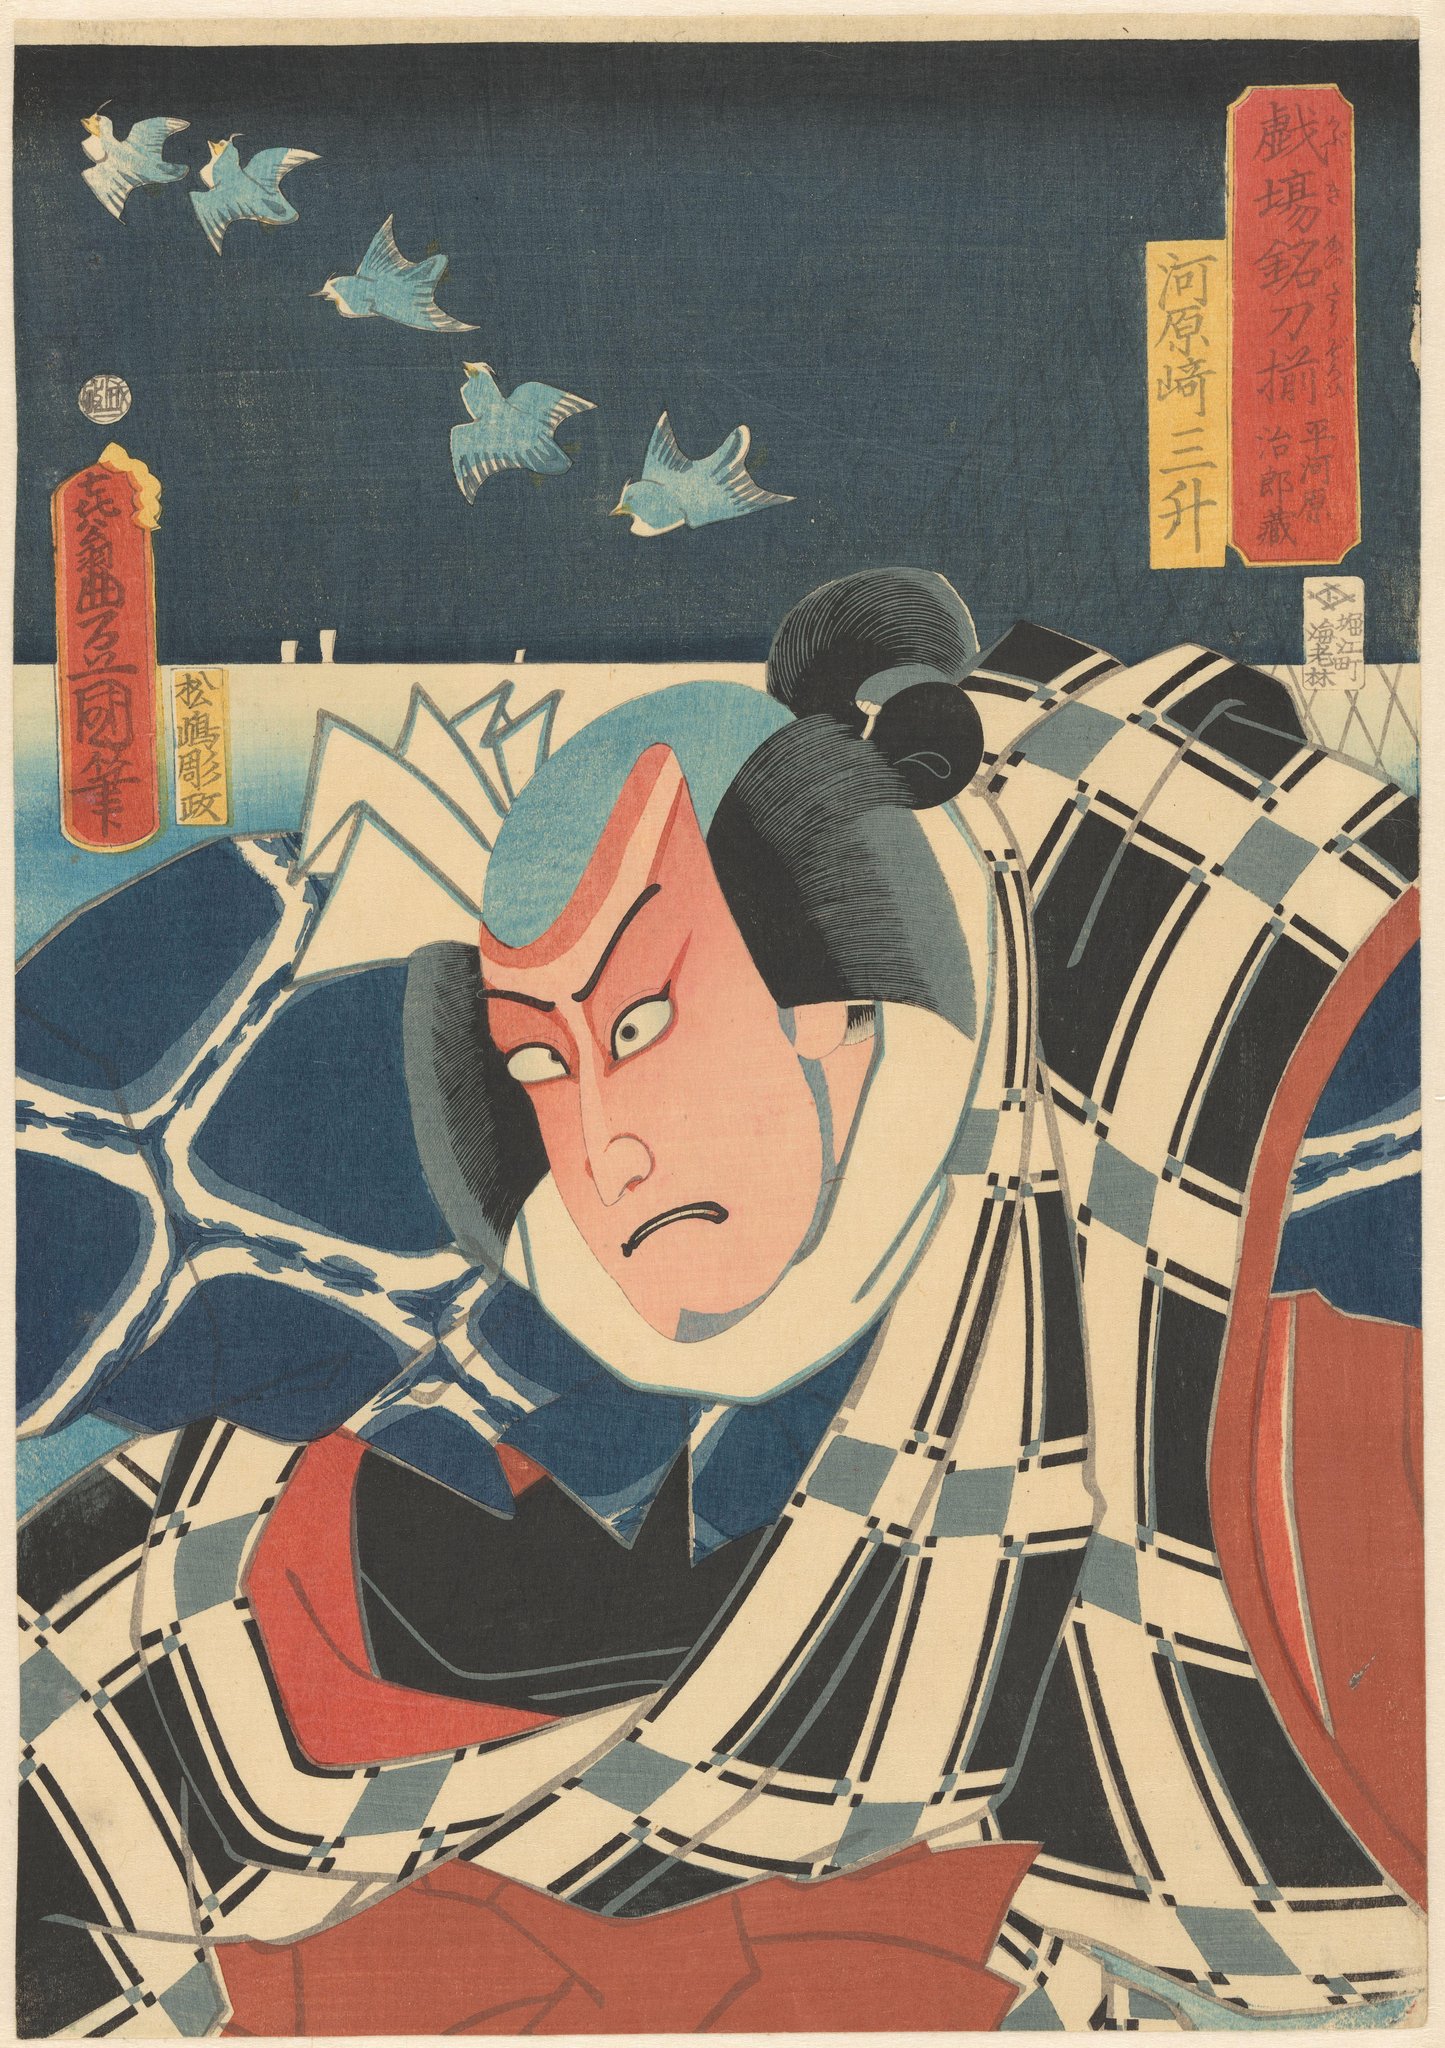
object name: print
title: Great swords of kabuki collected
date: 1801-1864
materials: paper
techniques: woodcut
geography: japan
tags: sailing-ship, sailing-boat, adult man, actor (on the stage)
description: Portret van kabuki acteur Kawarazaki Sanshô in de rol van Hiragawara no Jirozô. Op de achtergrond de zeilen van schepen en opvliegende plevieren.